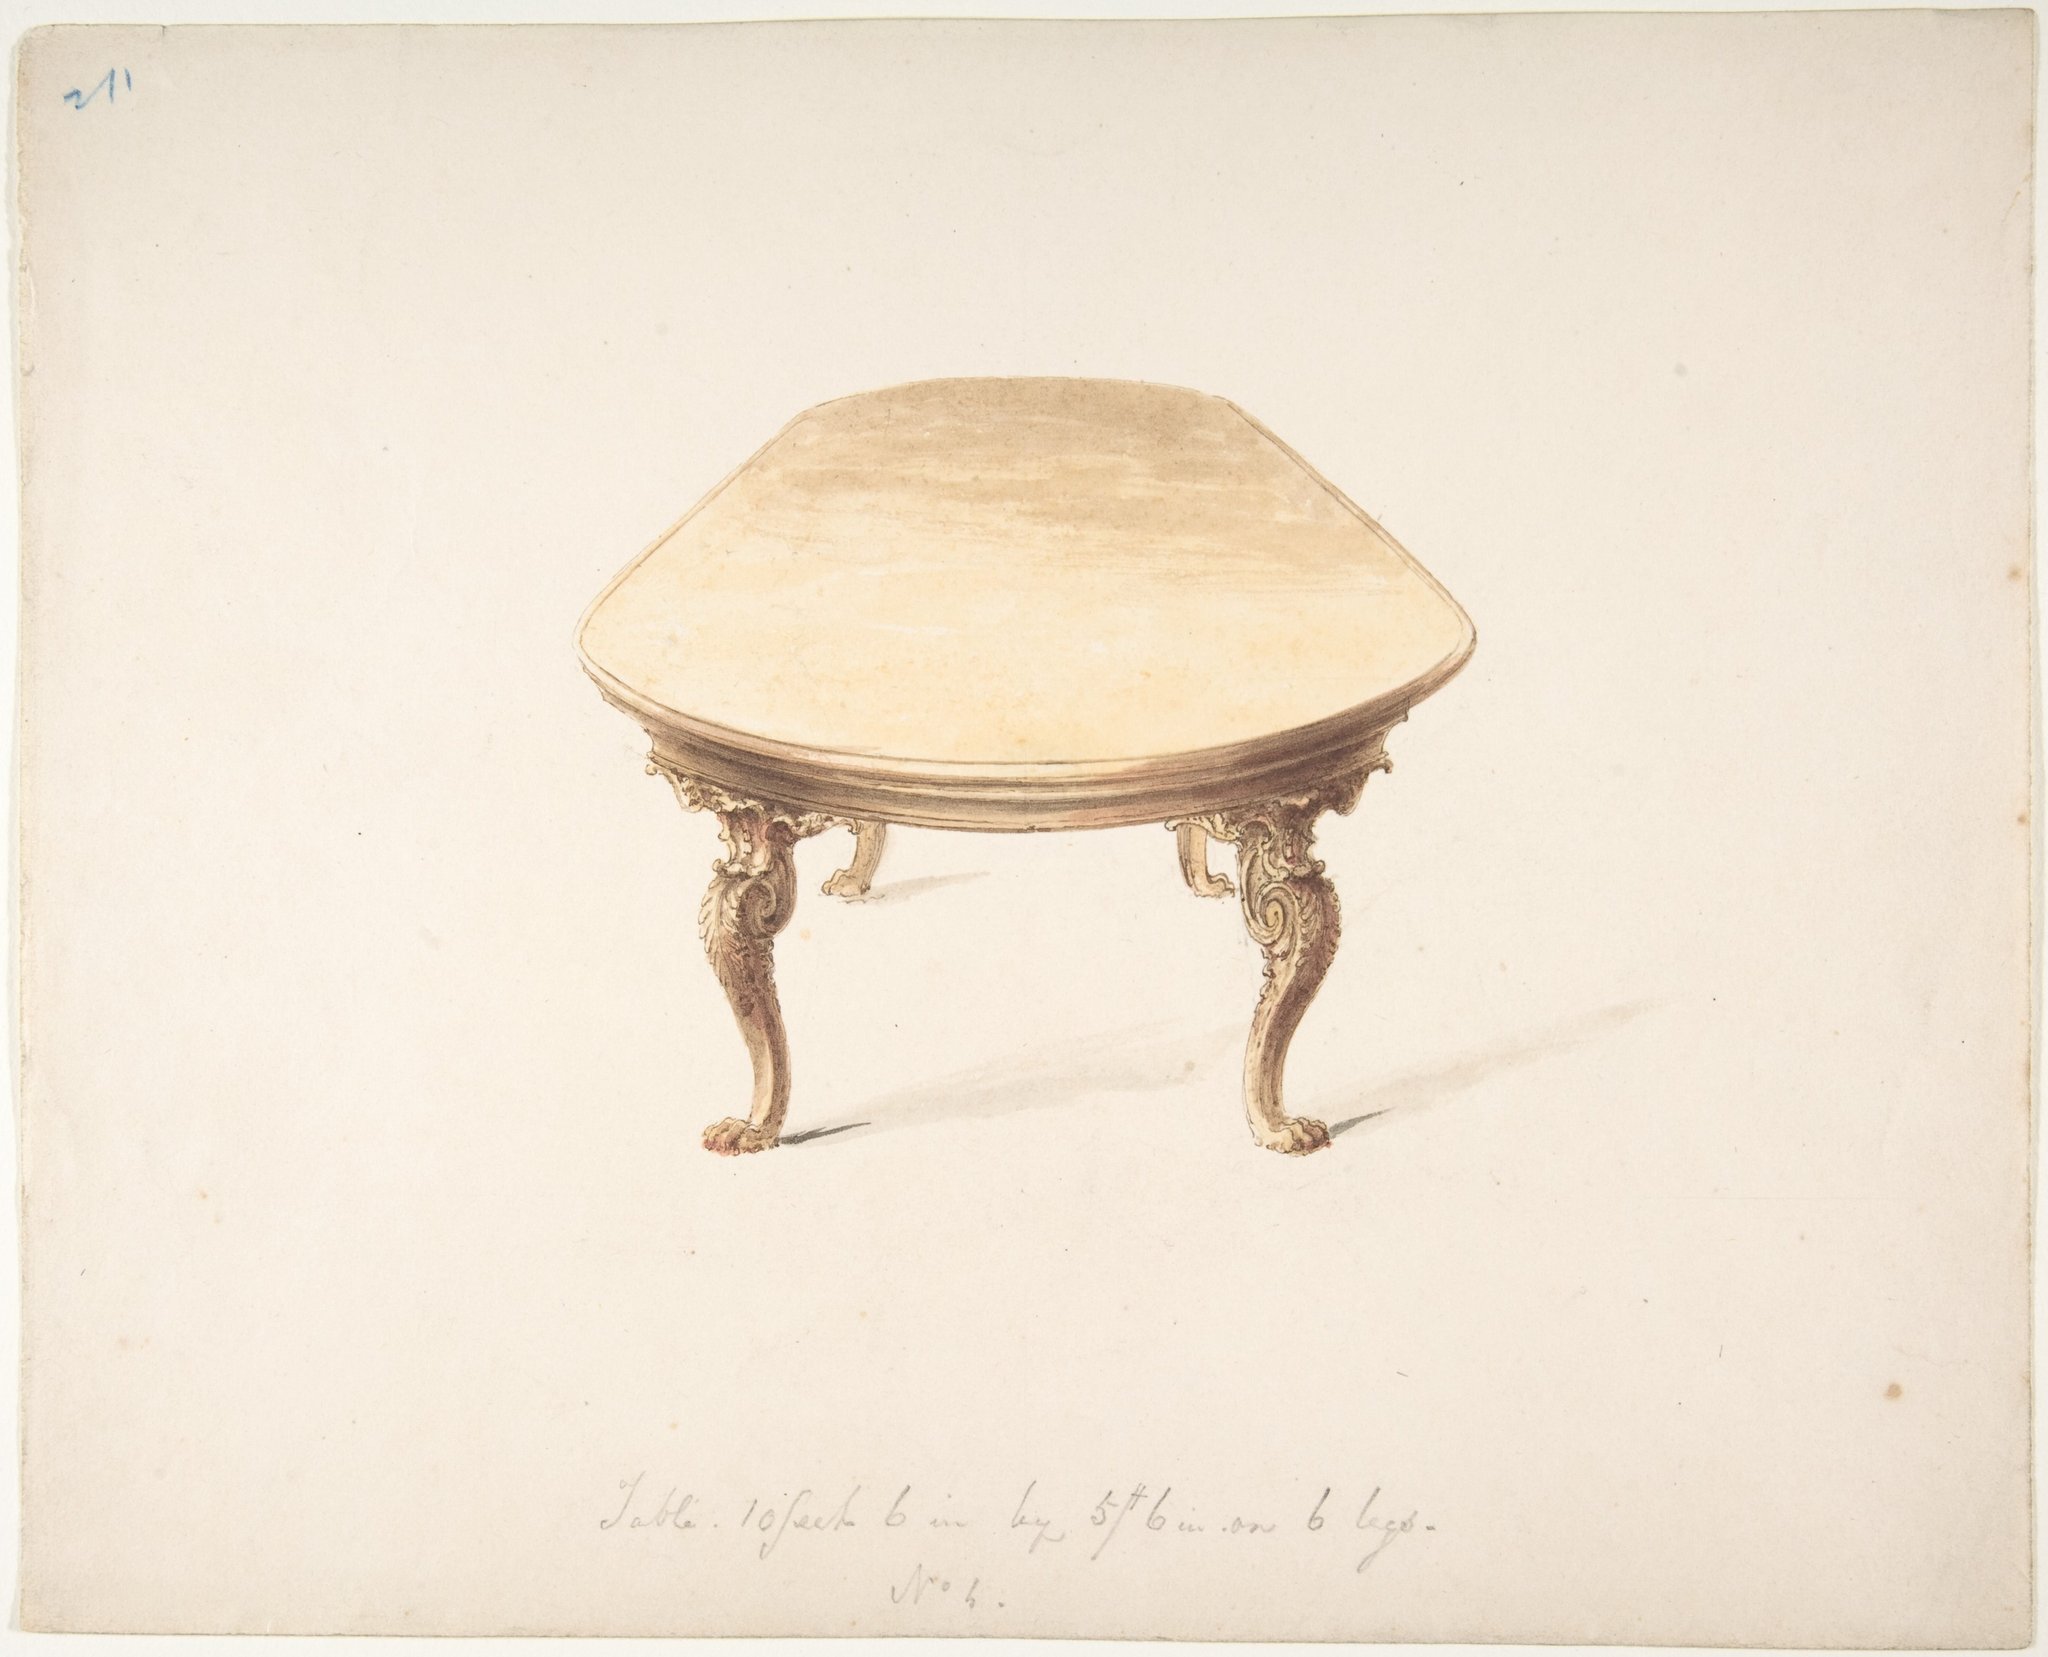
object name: drawing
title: Design for a Dining Table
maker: anonymous, british, 19th century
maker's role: artist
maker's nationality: british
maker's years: 1800-1900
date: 1801-1833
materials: ink, watercolor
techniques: brush, pen, wash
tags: tables